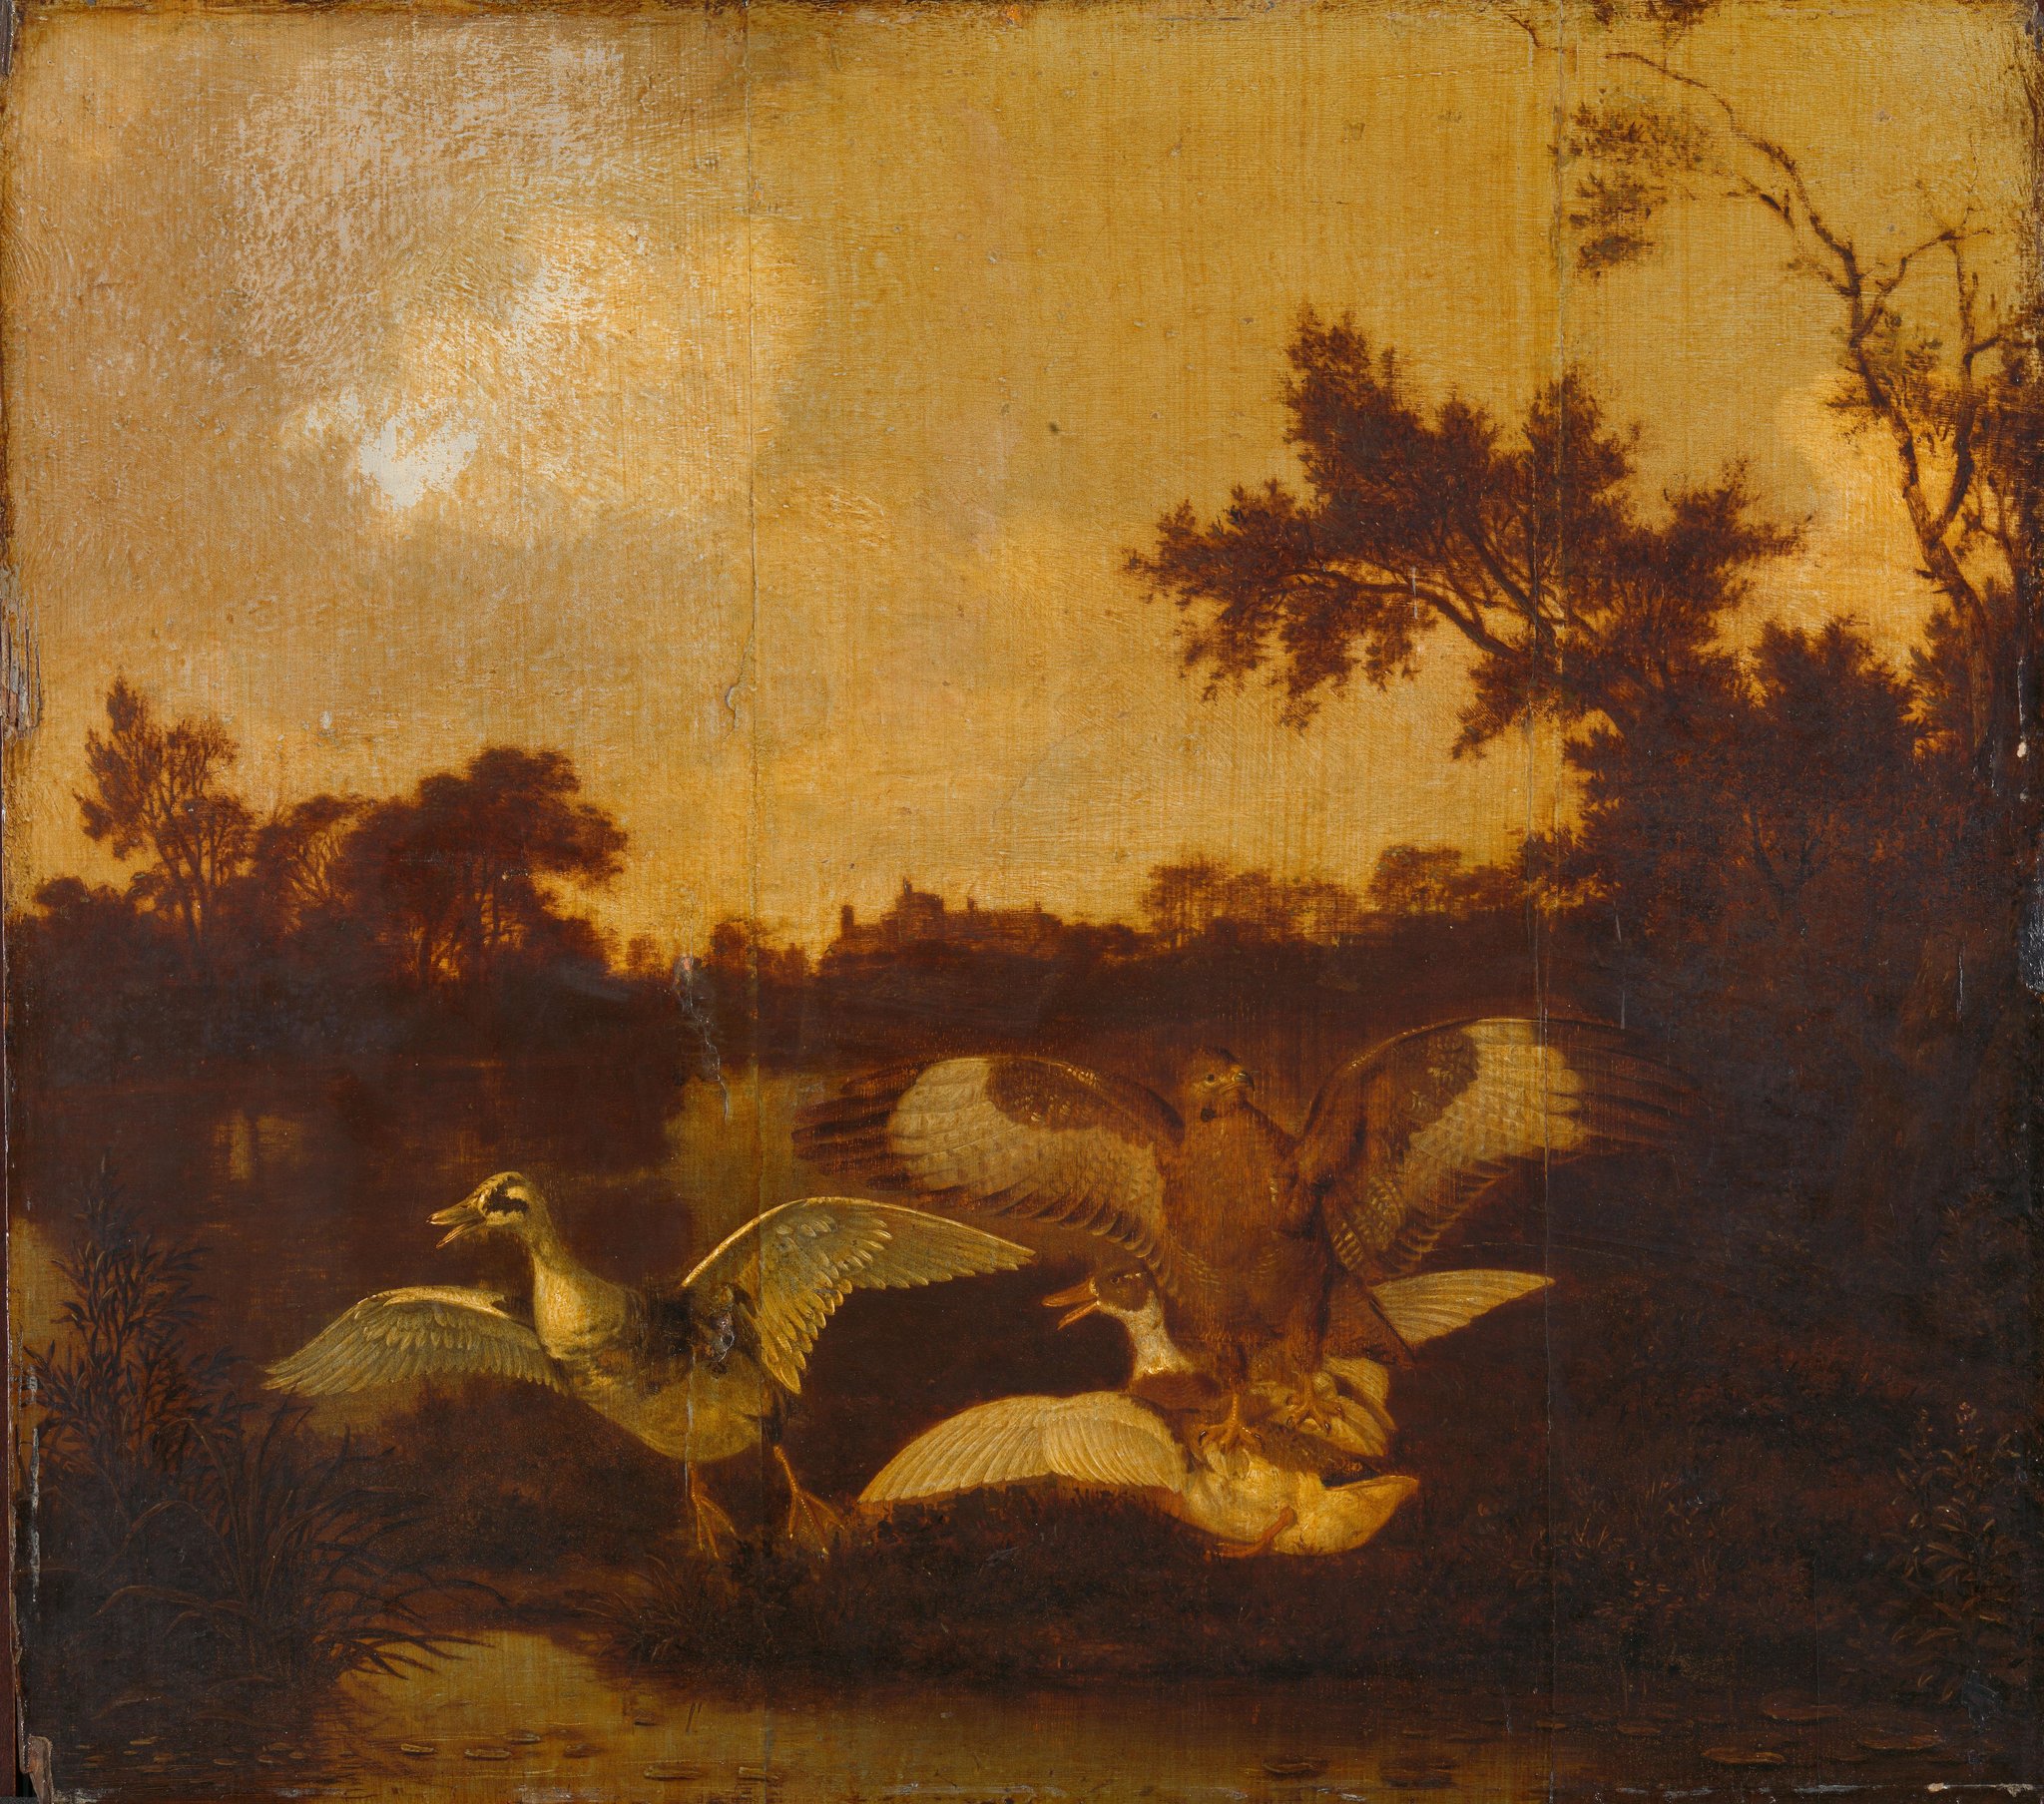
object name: painting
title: A Buzzard Attacking Two Ducks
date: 1652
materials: oil, panel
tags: water-birds: duck, predatory birds: buzzard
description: Bij de waterkant in een rivierlandschap valt een buizerd twee eenden aan.